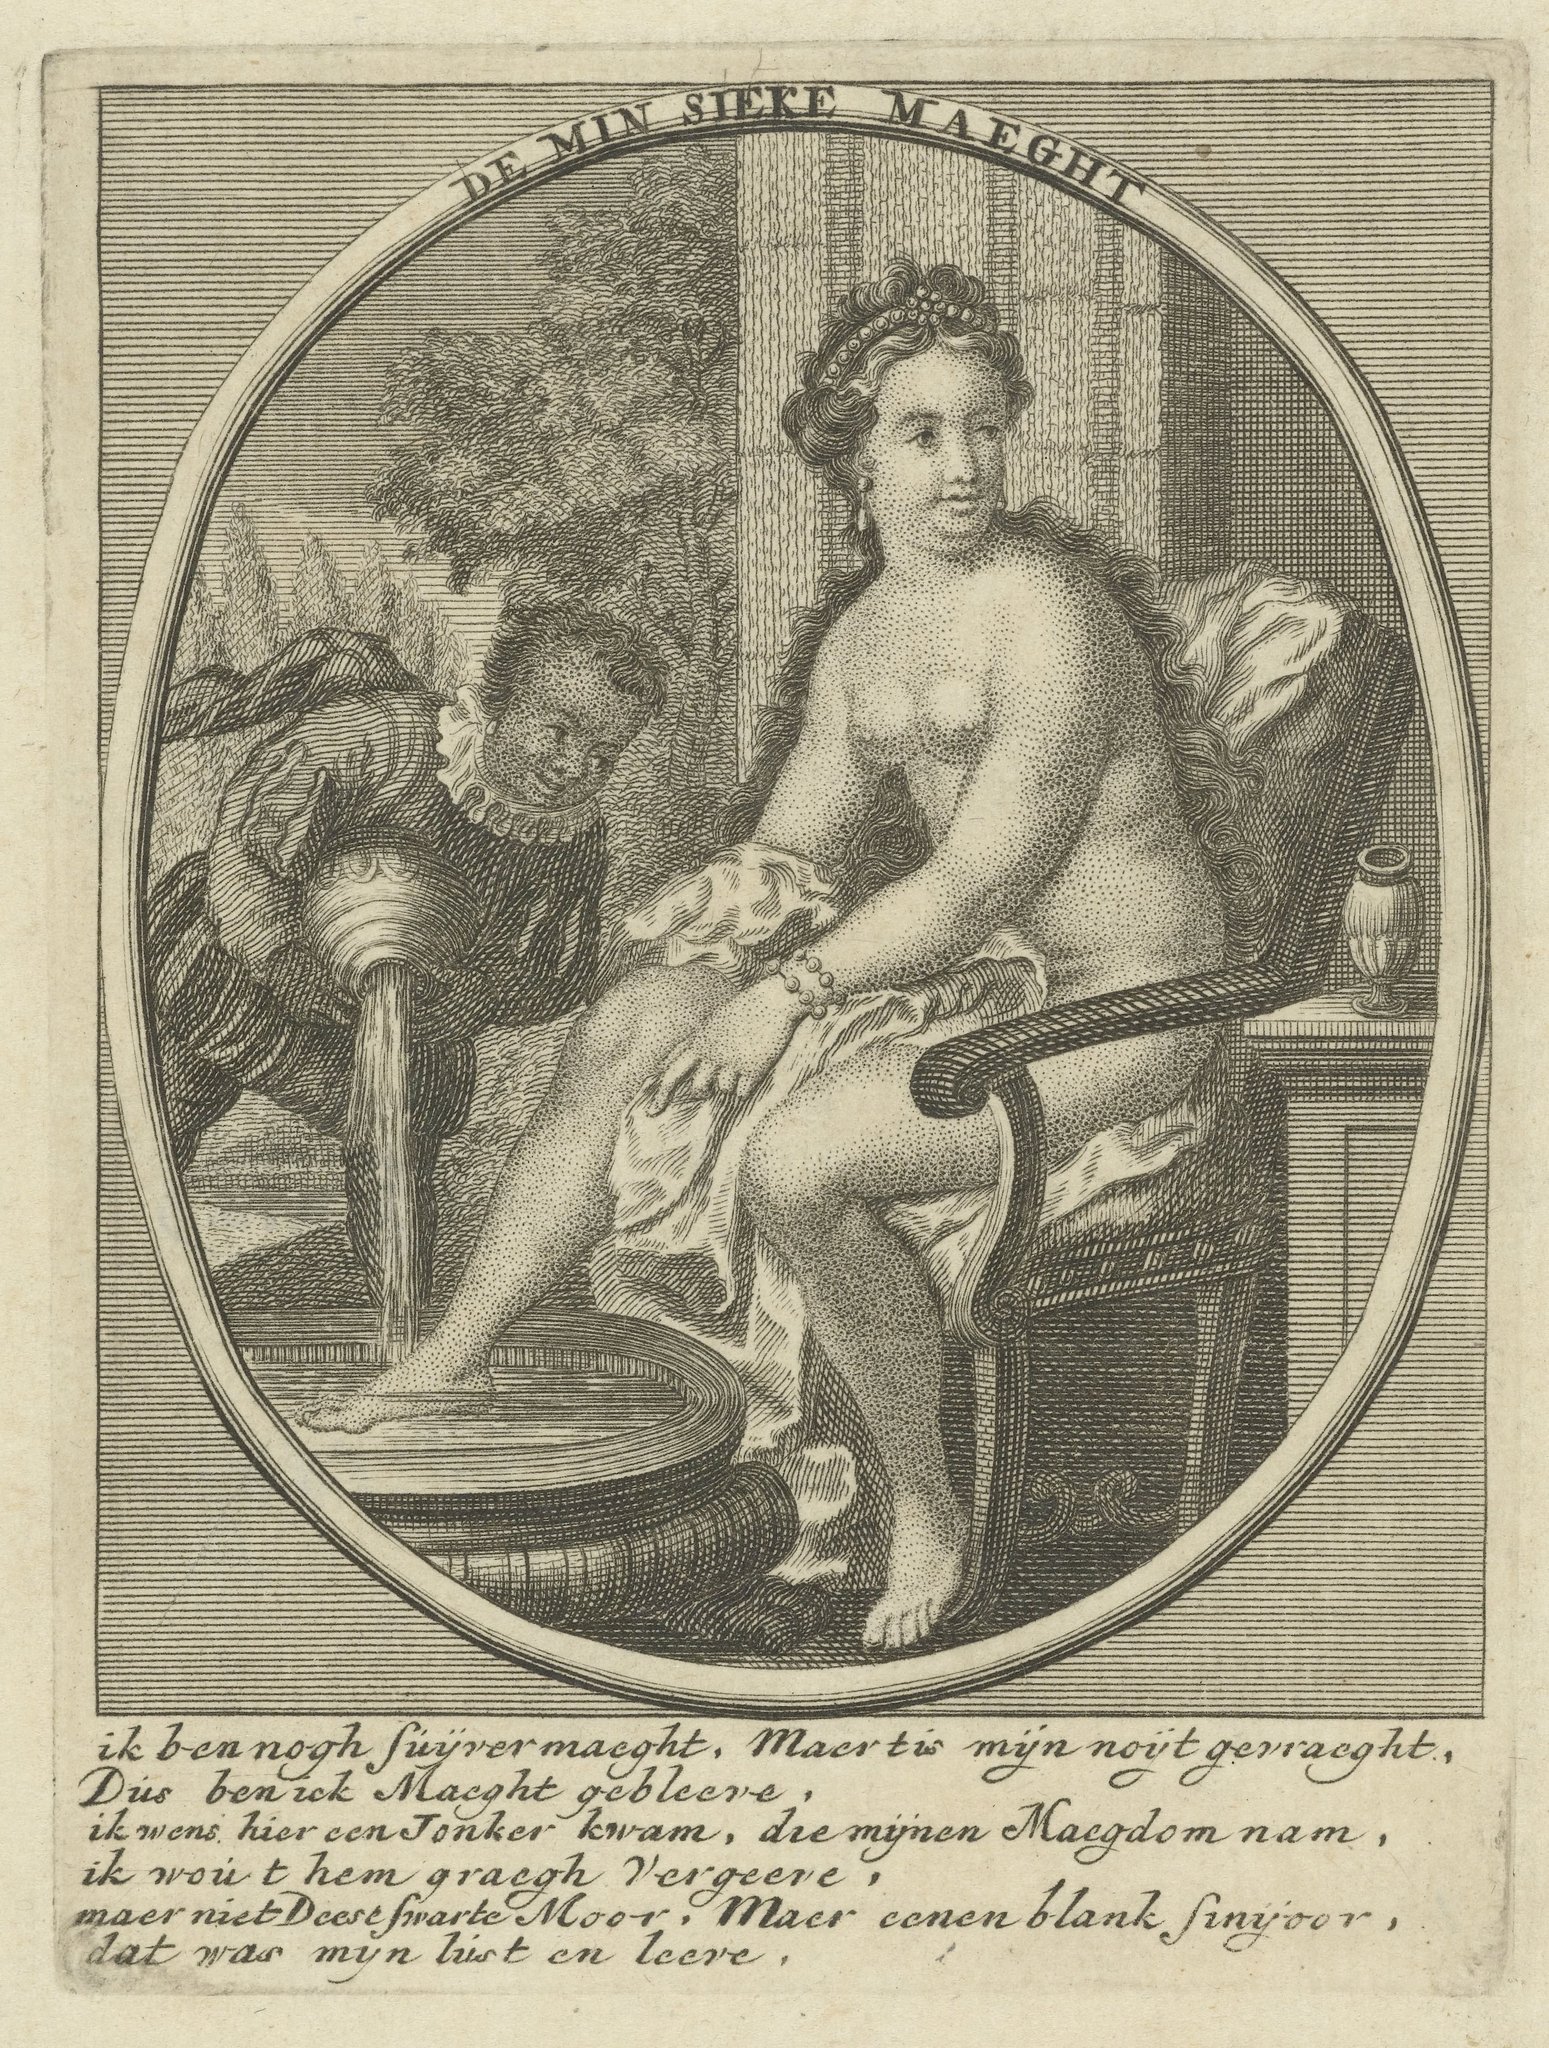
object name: print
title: De min sieke maeght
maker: Anonymous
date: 1700-1900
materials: paper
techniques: engraving, etching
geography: netherlands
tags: virginity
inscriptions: collector's mark: Lugt 2228, collector's mark: Lugt 2760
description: Een naakte maagd baadt haar voeten. Een zwarte man vult het voetenbad met water. Onder de voorstelling een dubbelzinnige vierregelige tekst in het Nederlands.